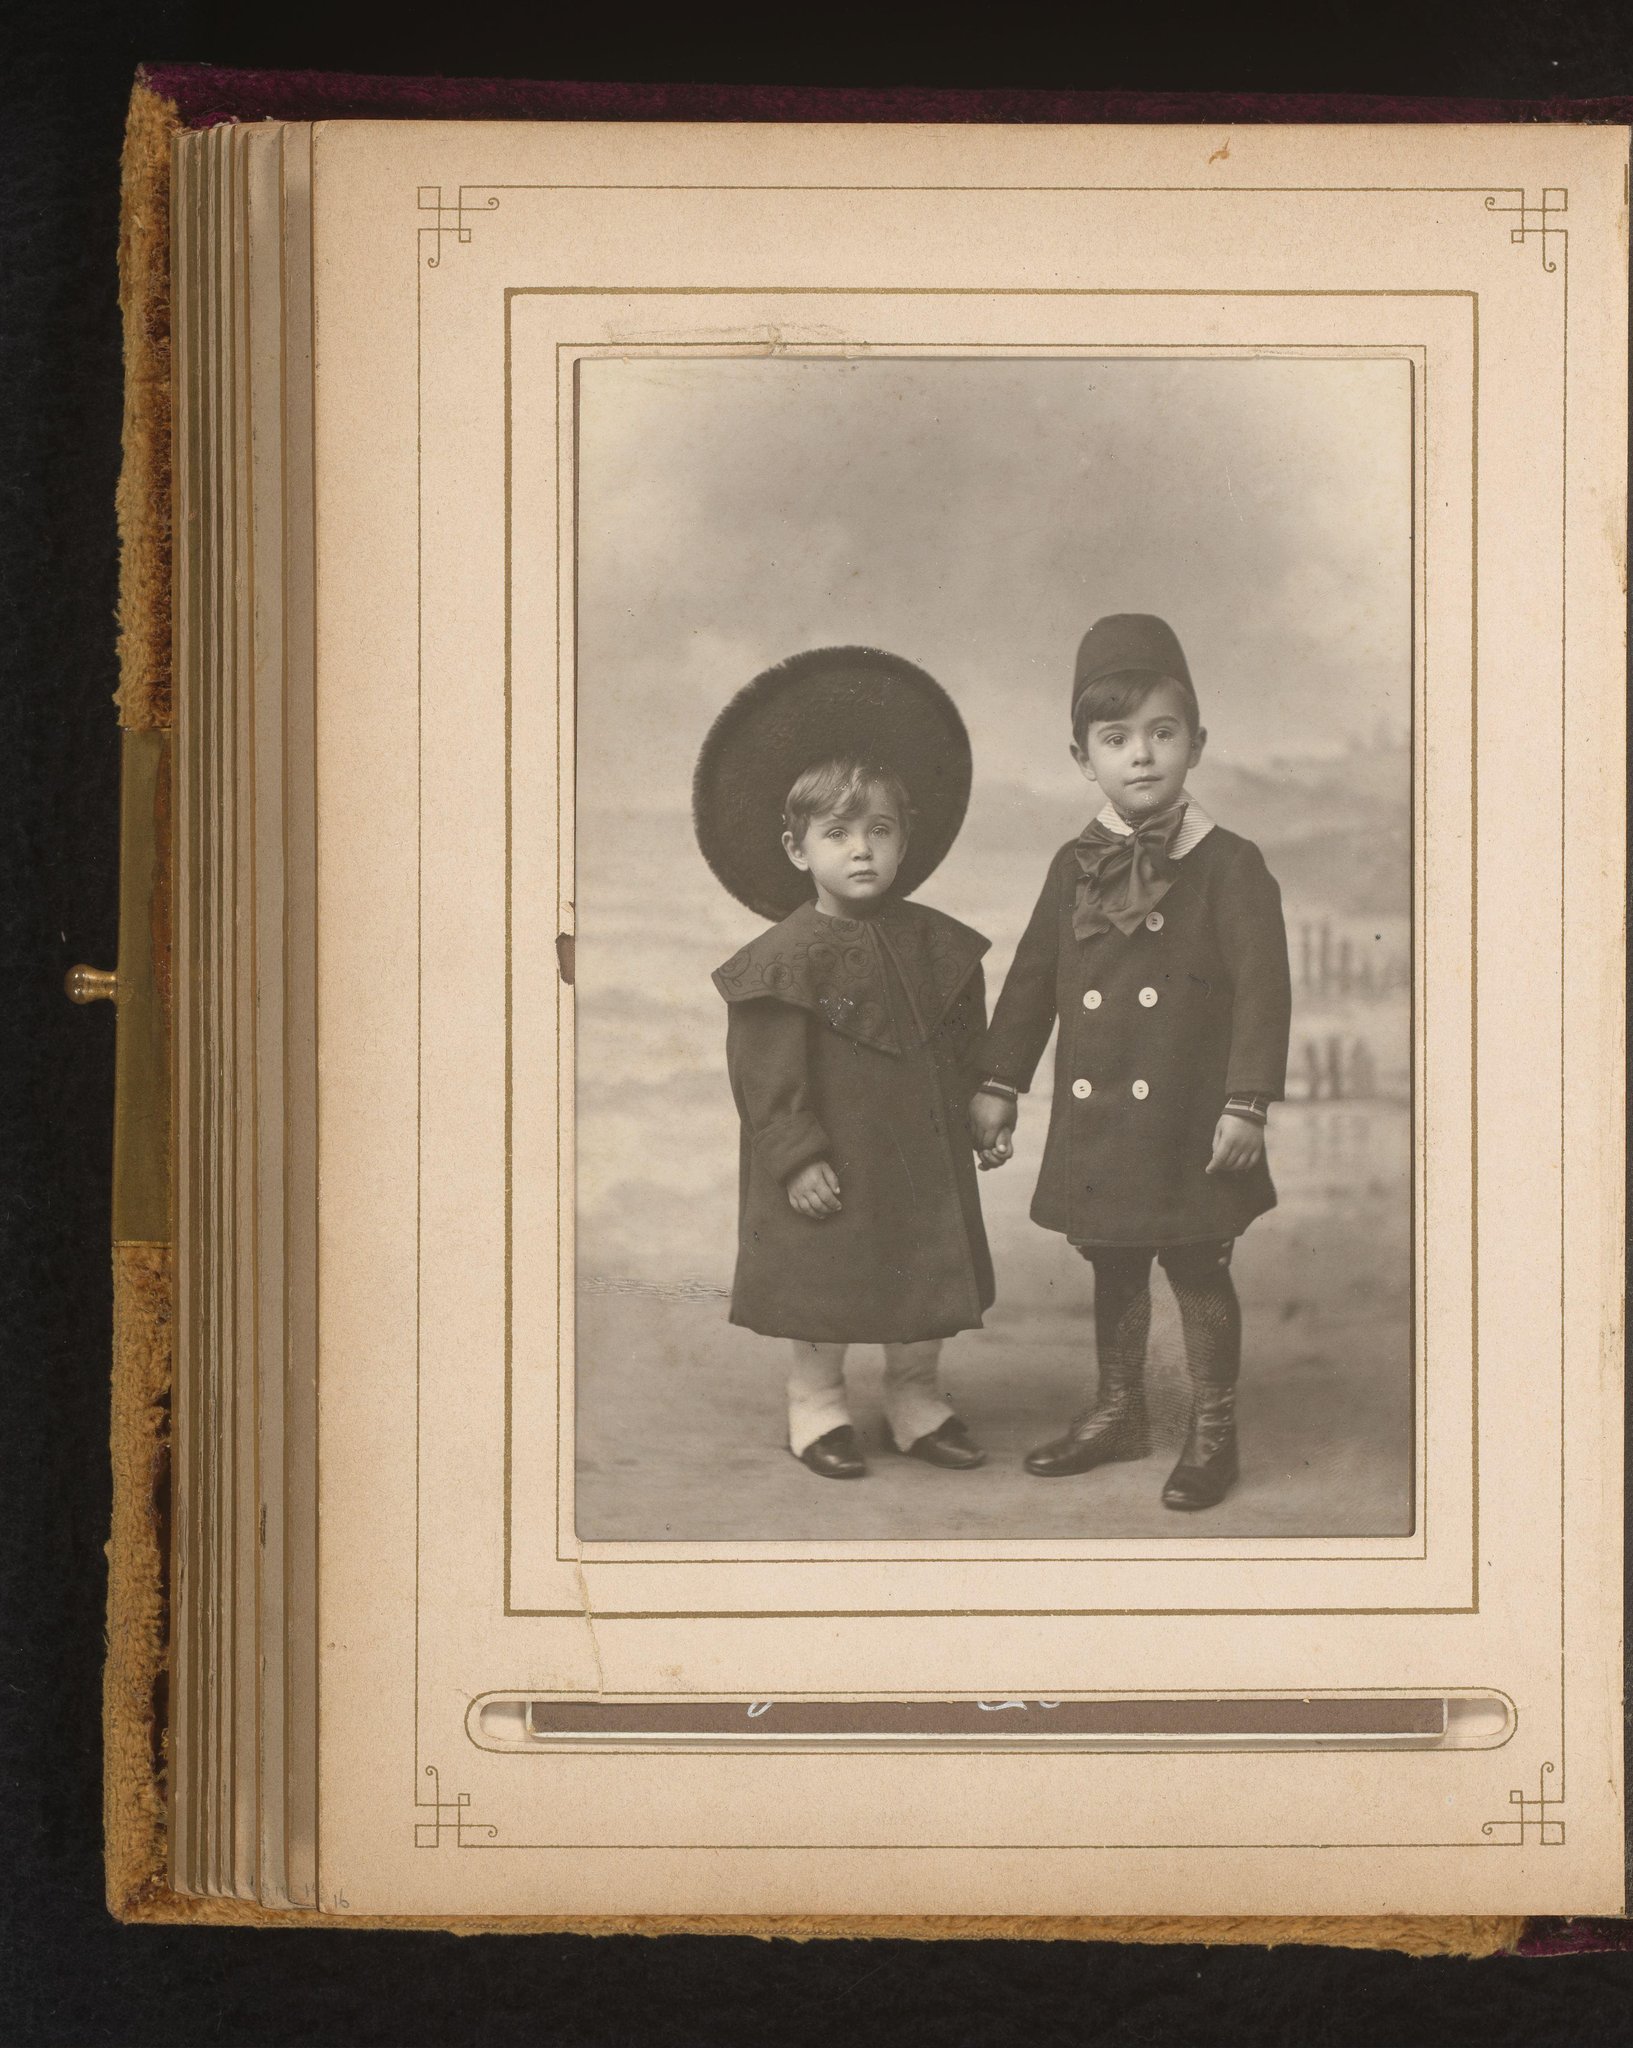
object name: cabinet photograph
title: Portret van twee kinderen, aangeduid als Johnny en Paul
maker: friedrich carel hisgen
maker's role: fotograaf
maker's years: 1846-1912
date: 1891-1912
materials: cardboard, photographic support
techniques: matte daylight collodion silver print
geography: amsterdam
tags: toddler (male) (+ two persons), historical persons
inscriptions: annotation: ‘Johnny 4 ans/ Paul 2 ans.’, inscription: ‘F. Hisgen/ P.C. Hooftstraat 72/ Atelier Parterre.’